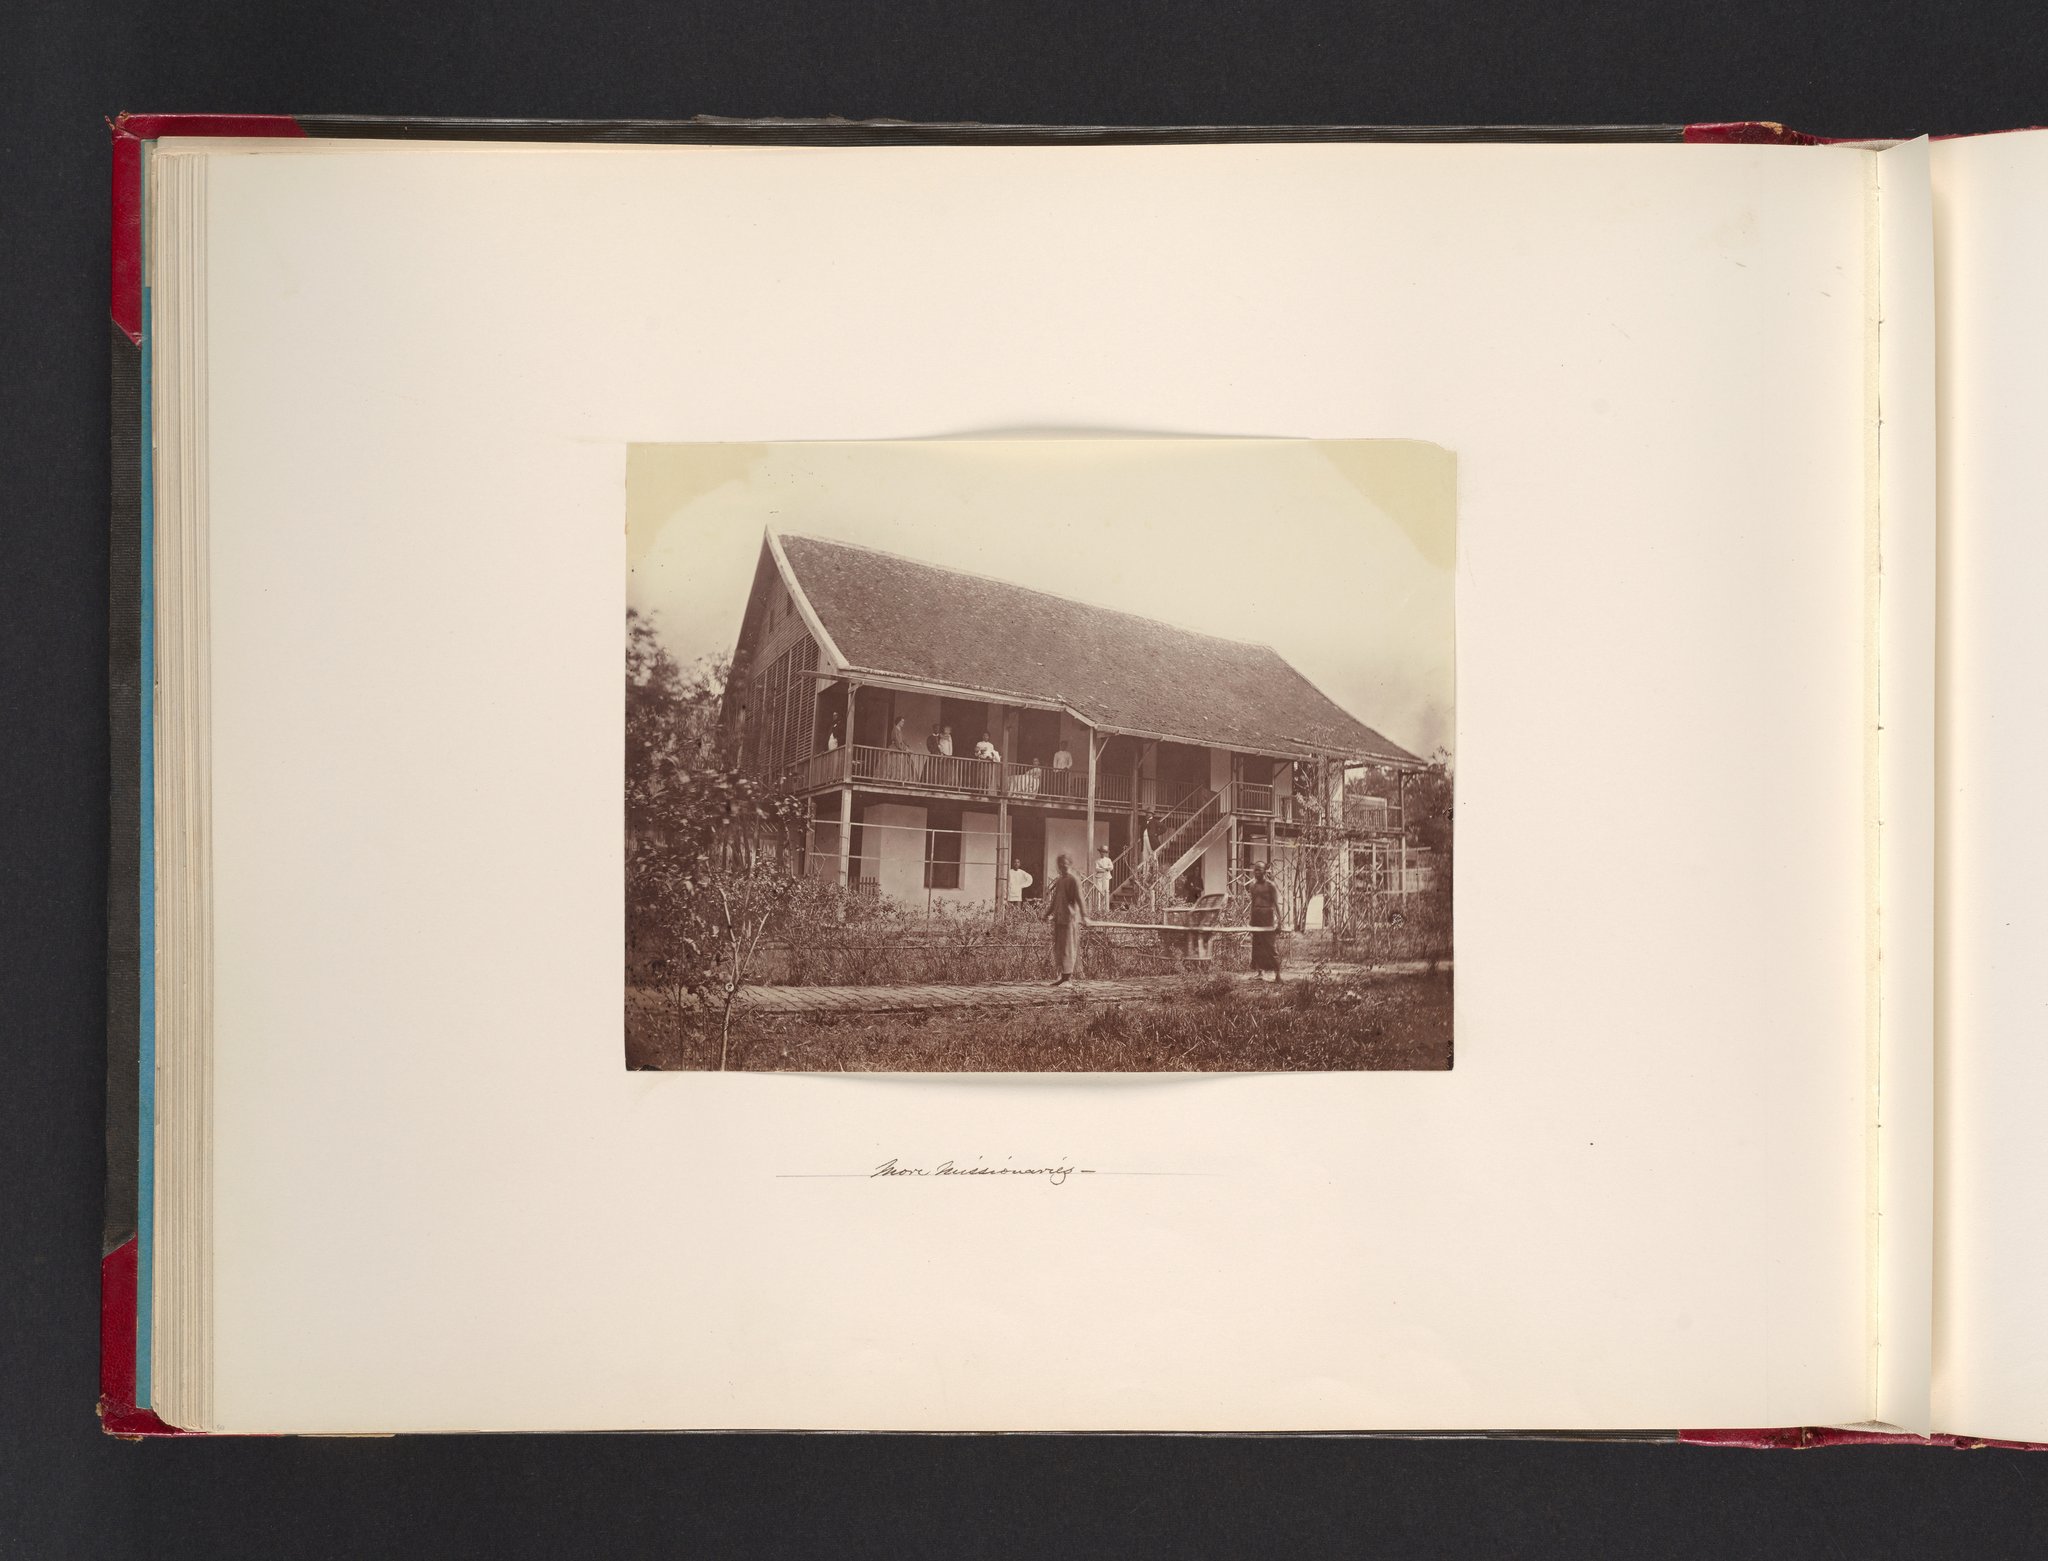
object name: photograph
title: More Missionaries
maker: john thomson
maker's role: artist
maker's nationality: british, scottish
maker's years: 1837-1921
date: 1865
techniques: albumen silver print, glass negative